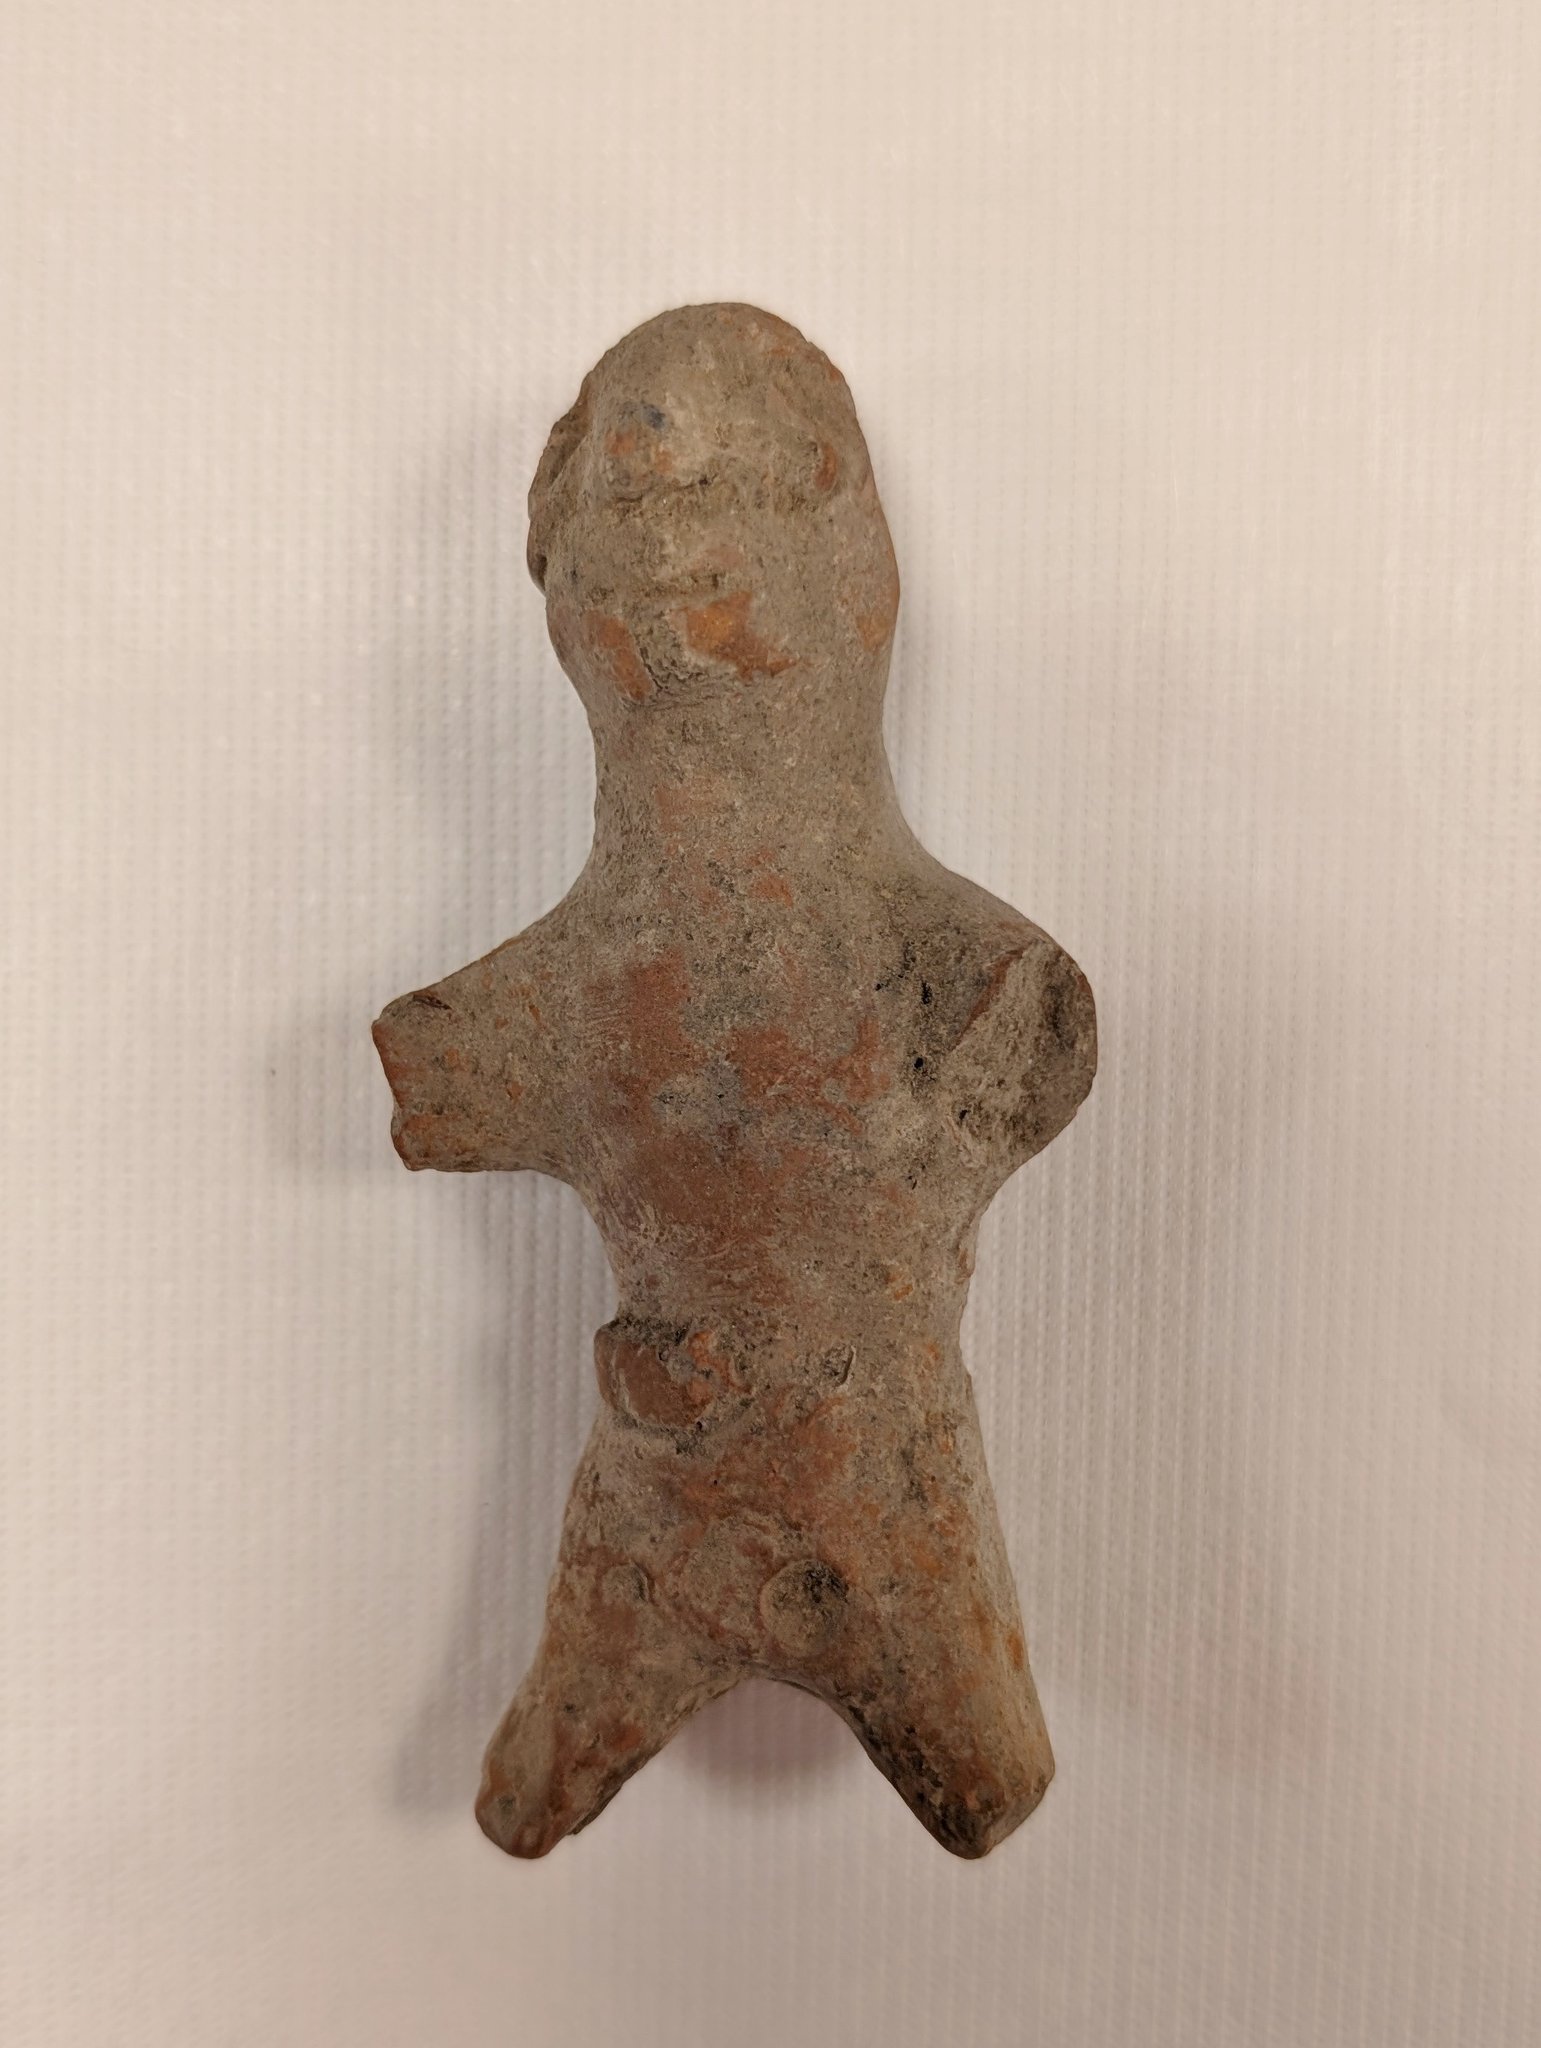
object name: plaque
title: Plaque in the Form of an Upright Figure (Study Collection)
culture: pakistani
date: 101-300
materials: terracotta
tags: gandhara